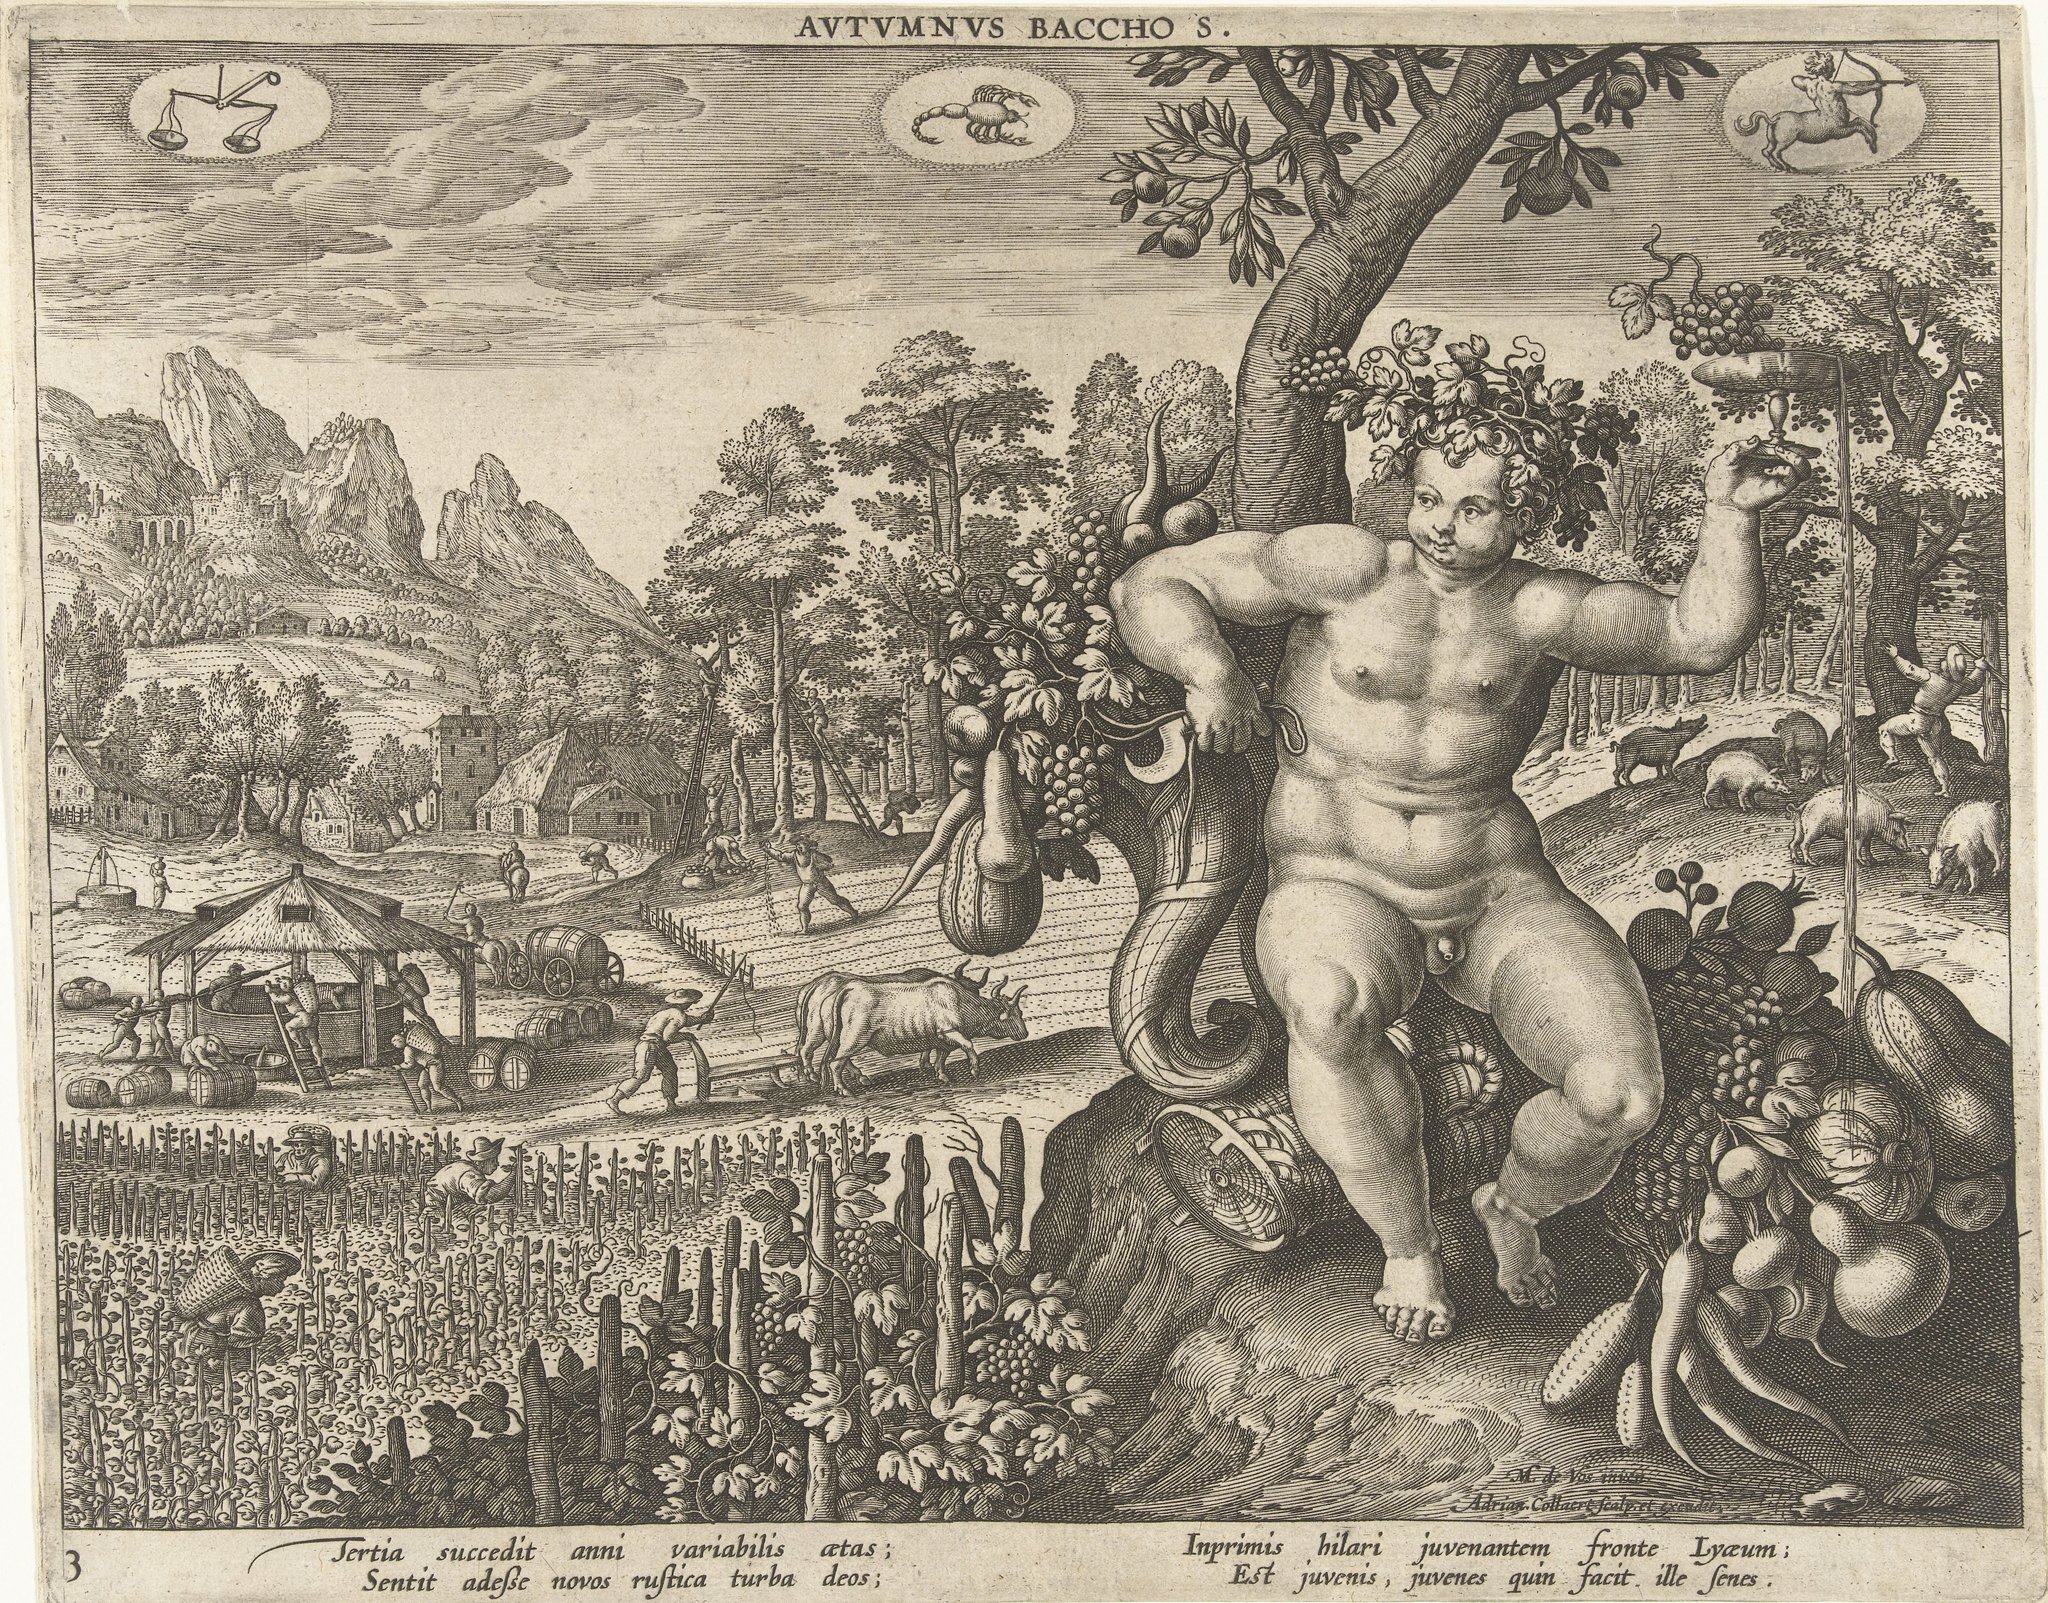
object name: print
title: Herfst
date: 1570-1618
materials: paper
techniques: engraving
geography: antwerp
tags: autumn, fall, 'autumnus'; 'autunno' (ripa), autumn landscape; landscape symbolizing autumn (the four seasons of the year) (+ with scenes showing human occupations ~ seasons and months), autumn landscape; landscape symbolizing autumn (the four seasons of the year) (+ with zodiacal signs of the autumn season)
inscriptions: collector's mark: Lugt 2228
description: Op de voorgrond de wijngod Bacchus. Naast hem de cornucopia en herfstvruchten. Op de achtergrond najaarstaferelen: ploegende en zaaiende boeren, de druivenoogst, de fruitoogst en het verzamelen van eikels voor de varkens. Boven in de lucht de drie astrologische tekens van het najaar: Weegschaal, Schorpioen en Boogschutter. De prent heeft een Latijns onderschrift en is deel van een vierdelige serie over de vier seizoenen.